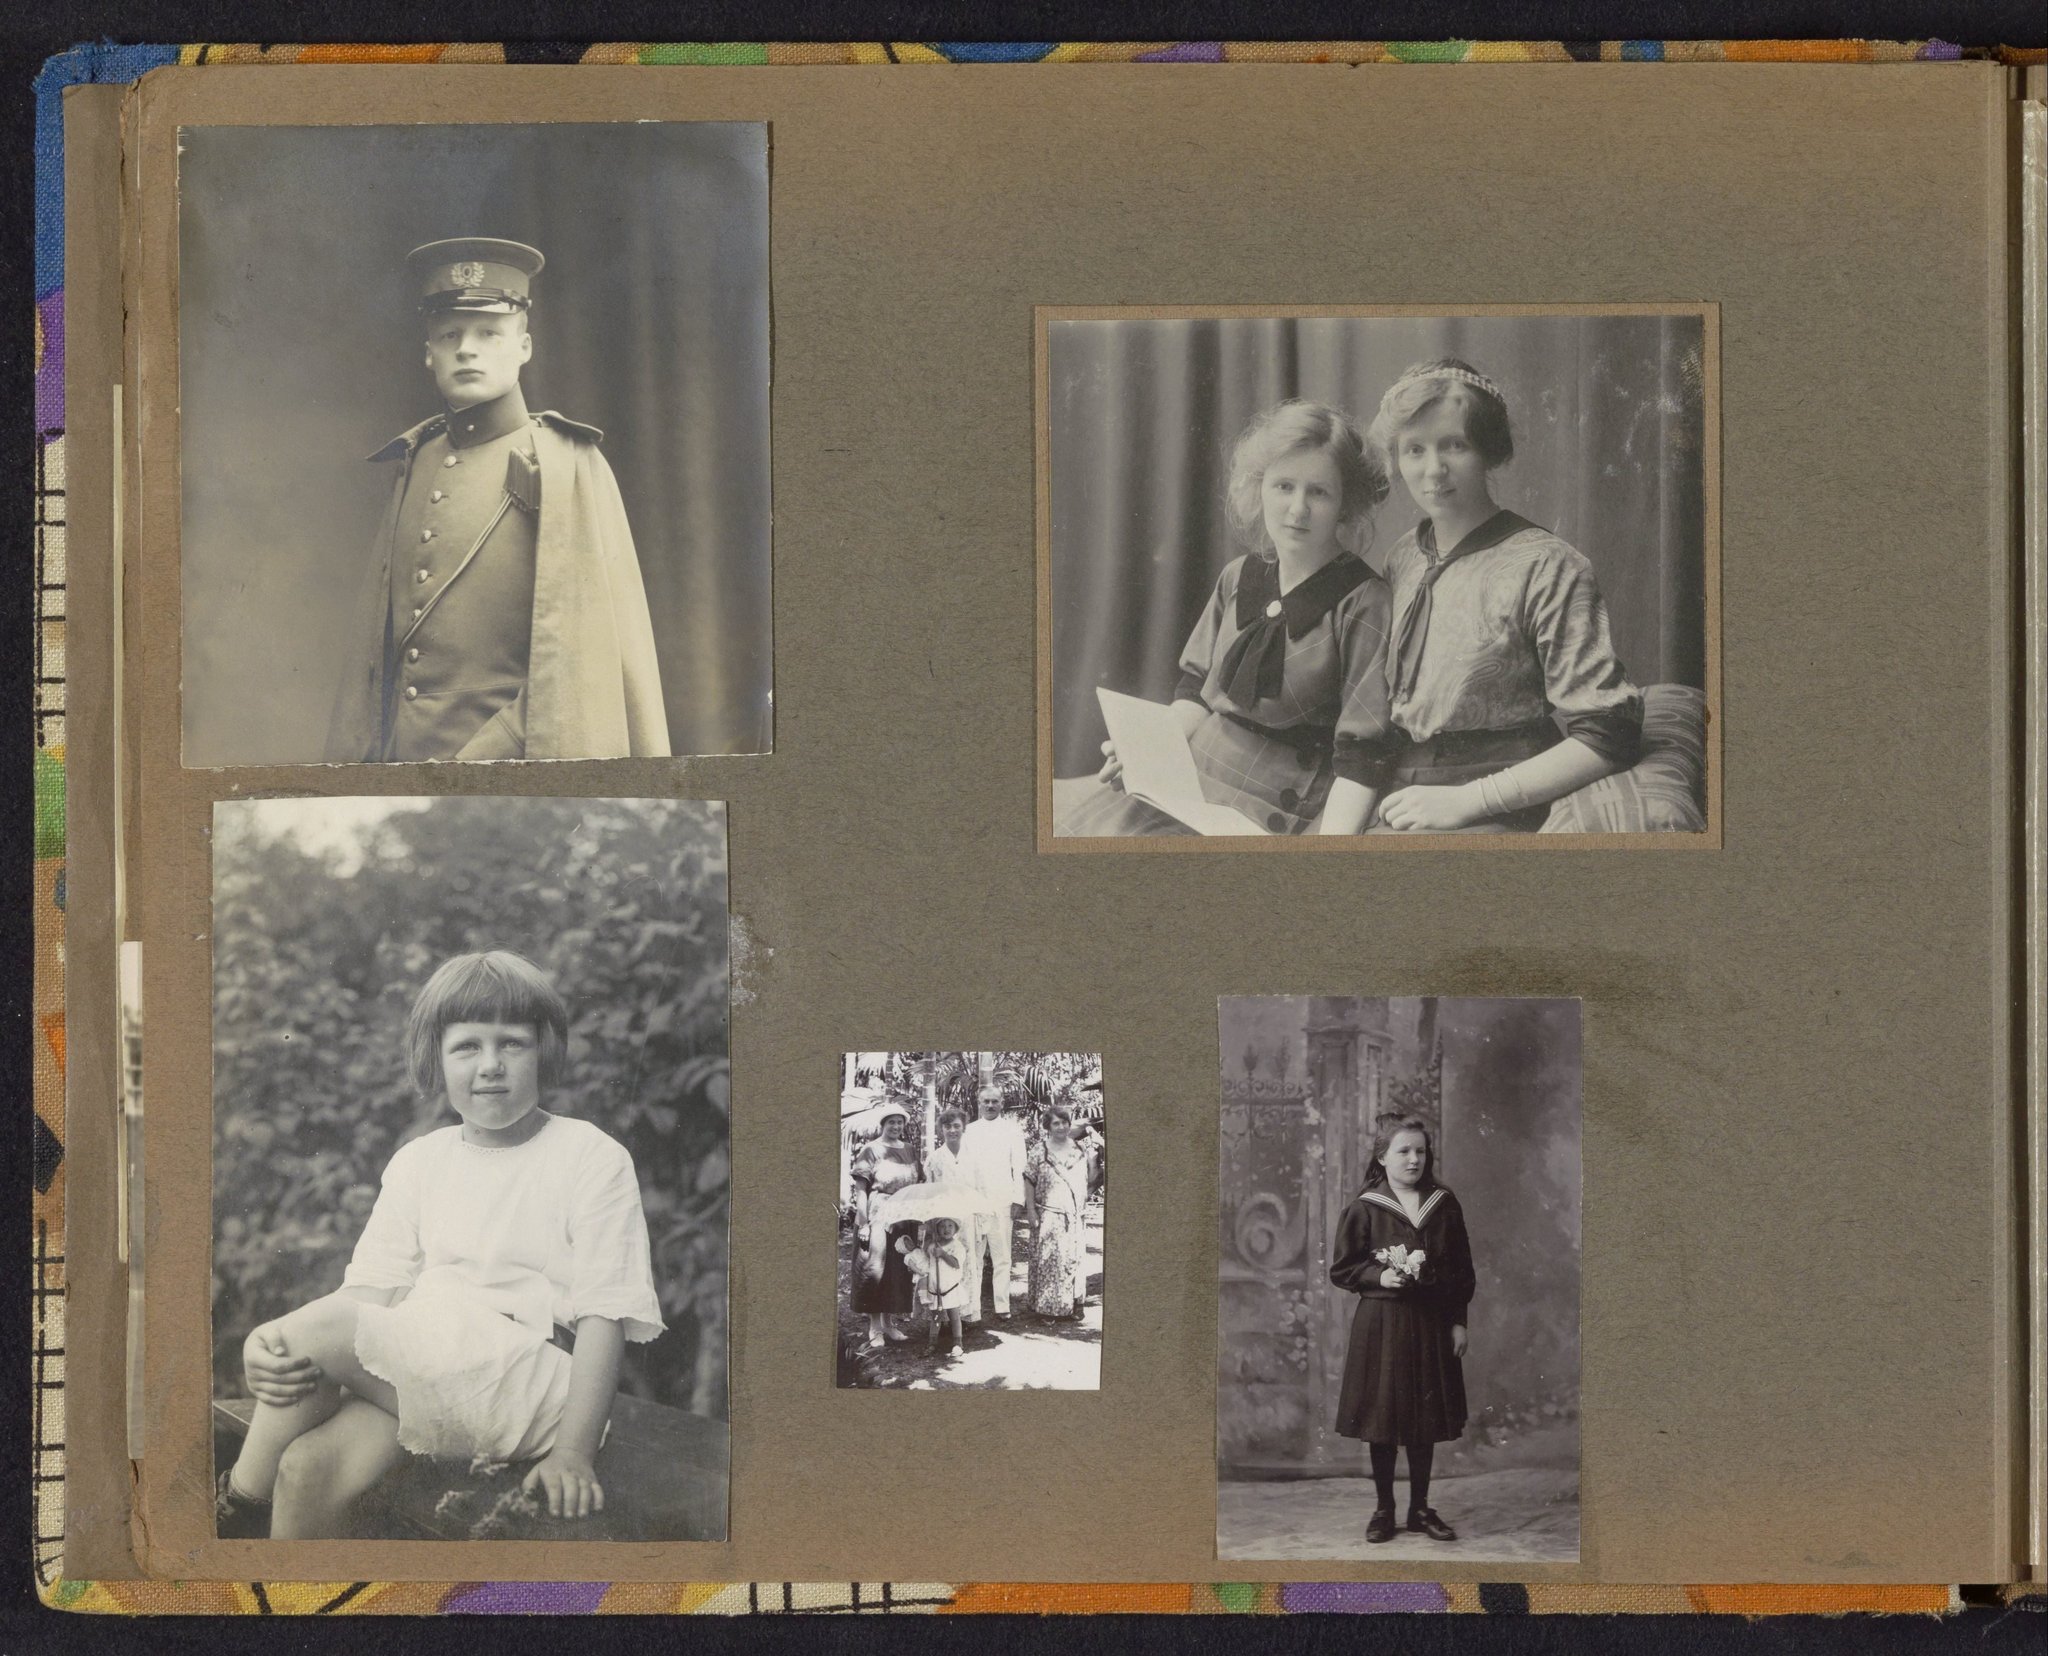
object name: album leaf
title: Portretten van volwassenen, kinderen en een militair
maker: Anonymous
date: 1900-1925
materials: cardboard, photographic support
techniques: gelatin silver print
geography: europe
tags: adult woman, adult man, child, (military) uniforms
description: Albumblad met portretten van volwassenen, kinderen en een militair in uniform. Ook een opname van een gezelschap in een tropische omgeving, mogelijk in Nederlands-Indië. Onderdeel van Fotoalbum van een onbekende Nederlandse familie met connecties in Suriname en Nederlands-Indië (1).